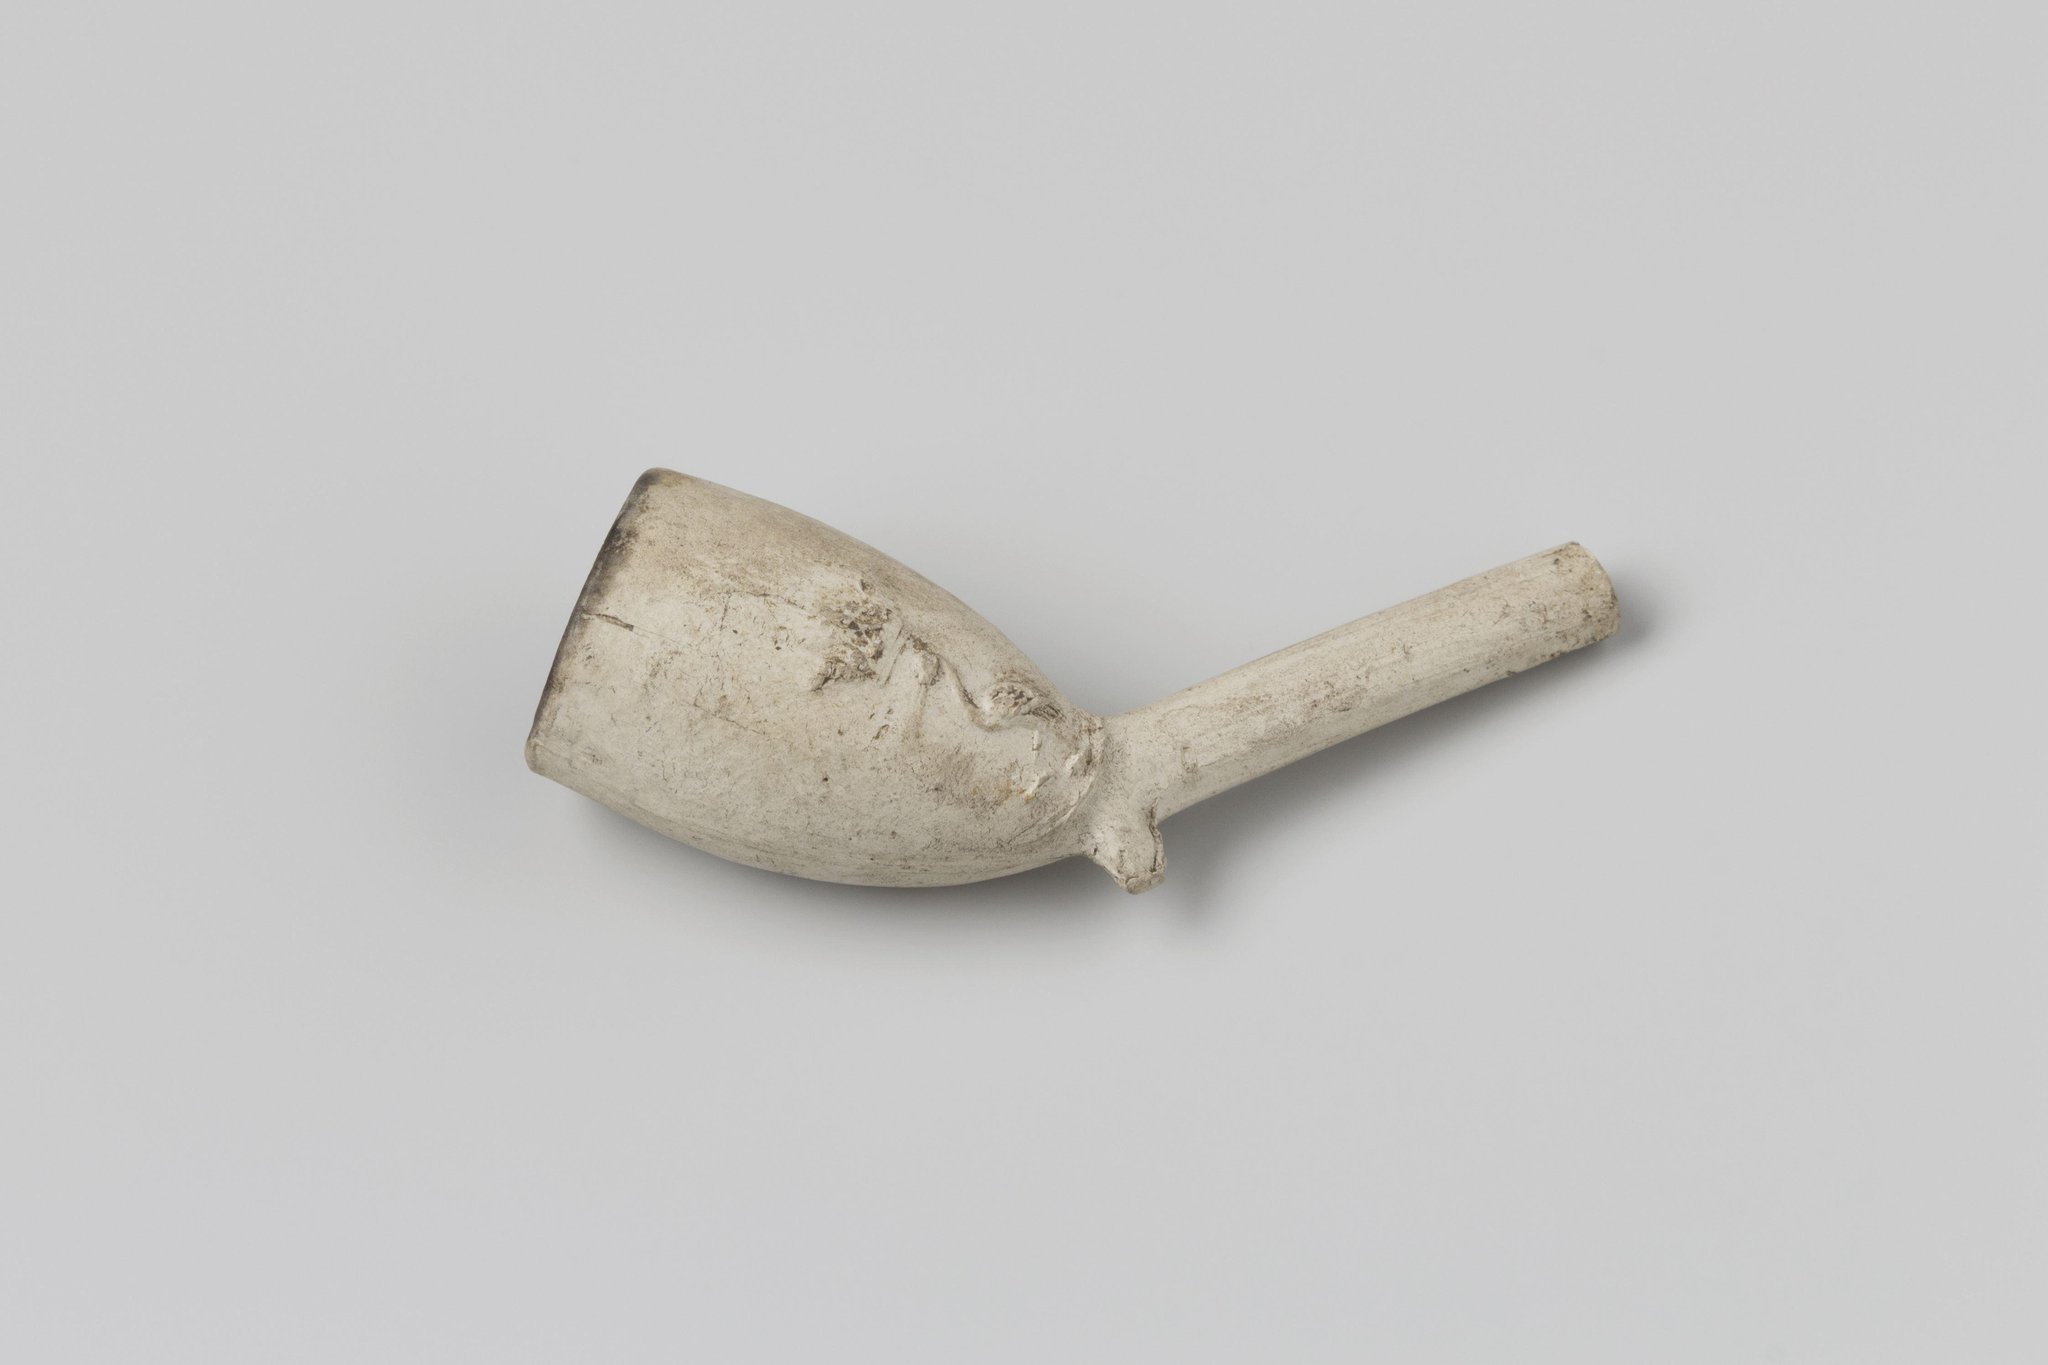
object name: fragment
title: Fragment tabakspijp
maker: Anonymous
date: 1750-1800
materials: clay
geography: netherlands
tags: rotterdam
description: Fragment tabakspijp met een kroon en daaronder een ooievaar afgebeeld. Van de opgravingen op de Hofstede Arentsburg 1827-1831 onder toezicht van Professor Reuvens.